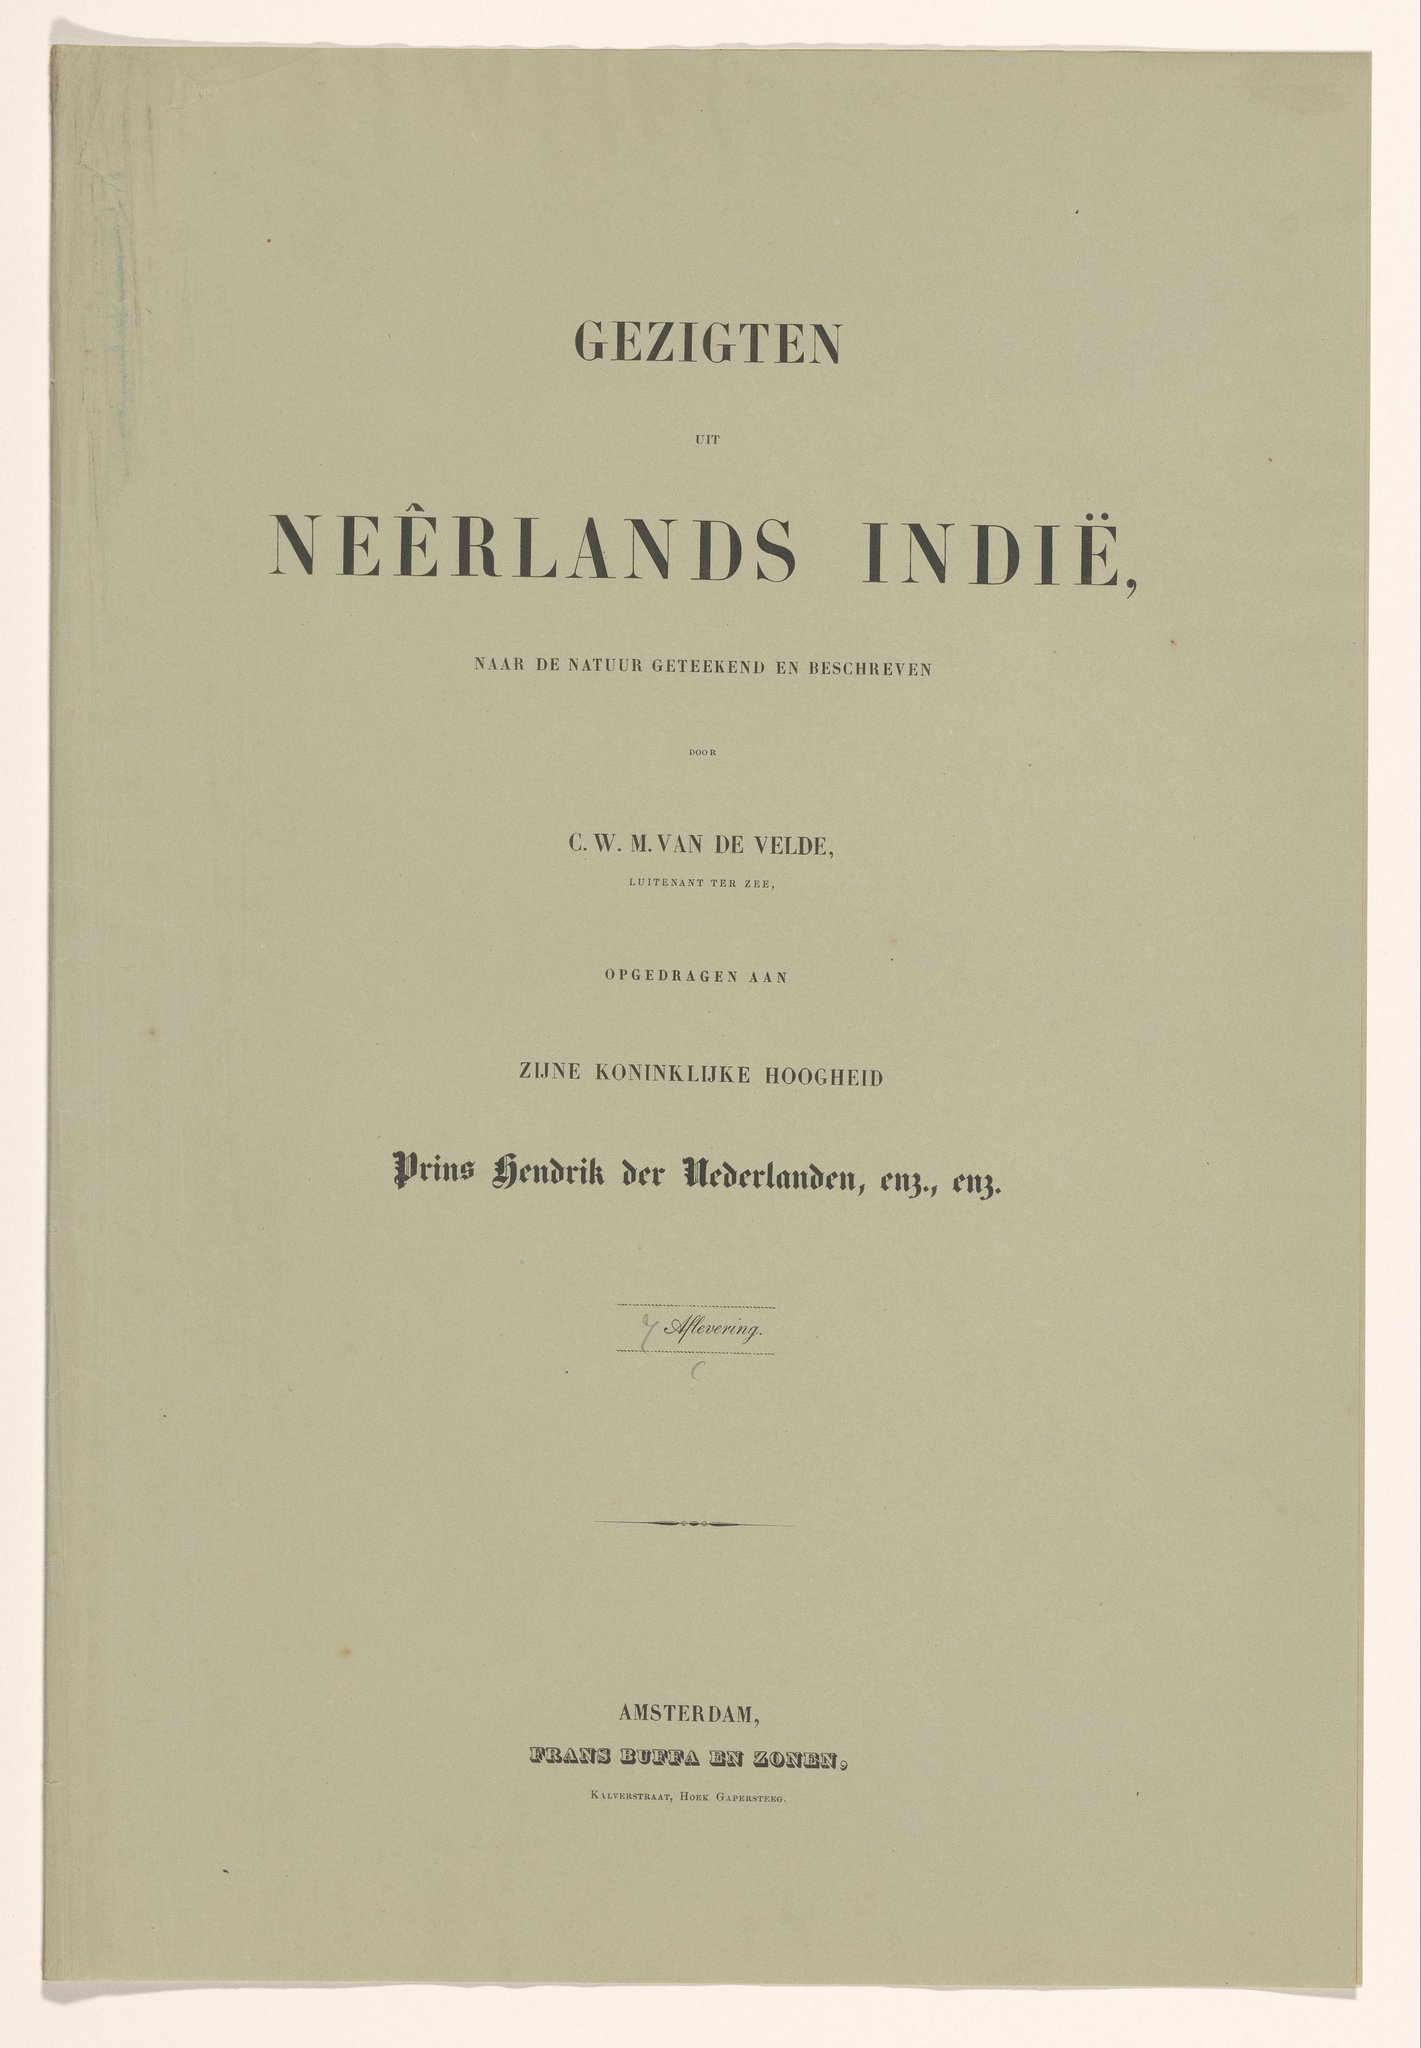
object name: wrapper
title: Gezigten uit Neêrlands Indië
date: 1843-1845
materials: paper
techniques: lithograph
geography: indonesia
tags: landscapes in the non-temperate zone, exotic landscapes, dutch east indies, the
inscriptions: inscription: ‘7 C’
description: Omslag met elf losse bladen waaronder twee tekstbladen en negen lithografieën. De omslag maakt deel uit van een map met twaalf omslagen.